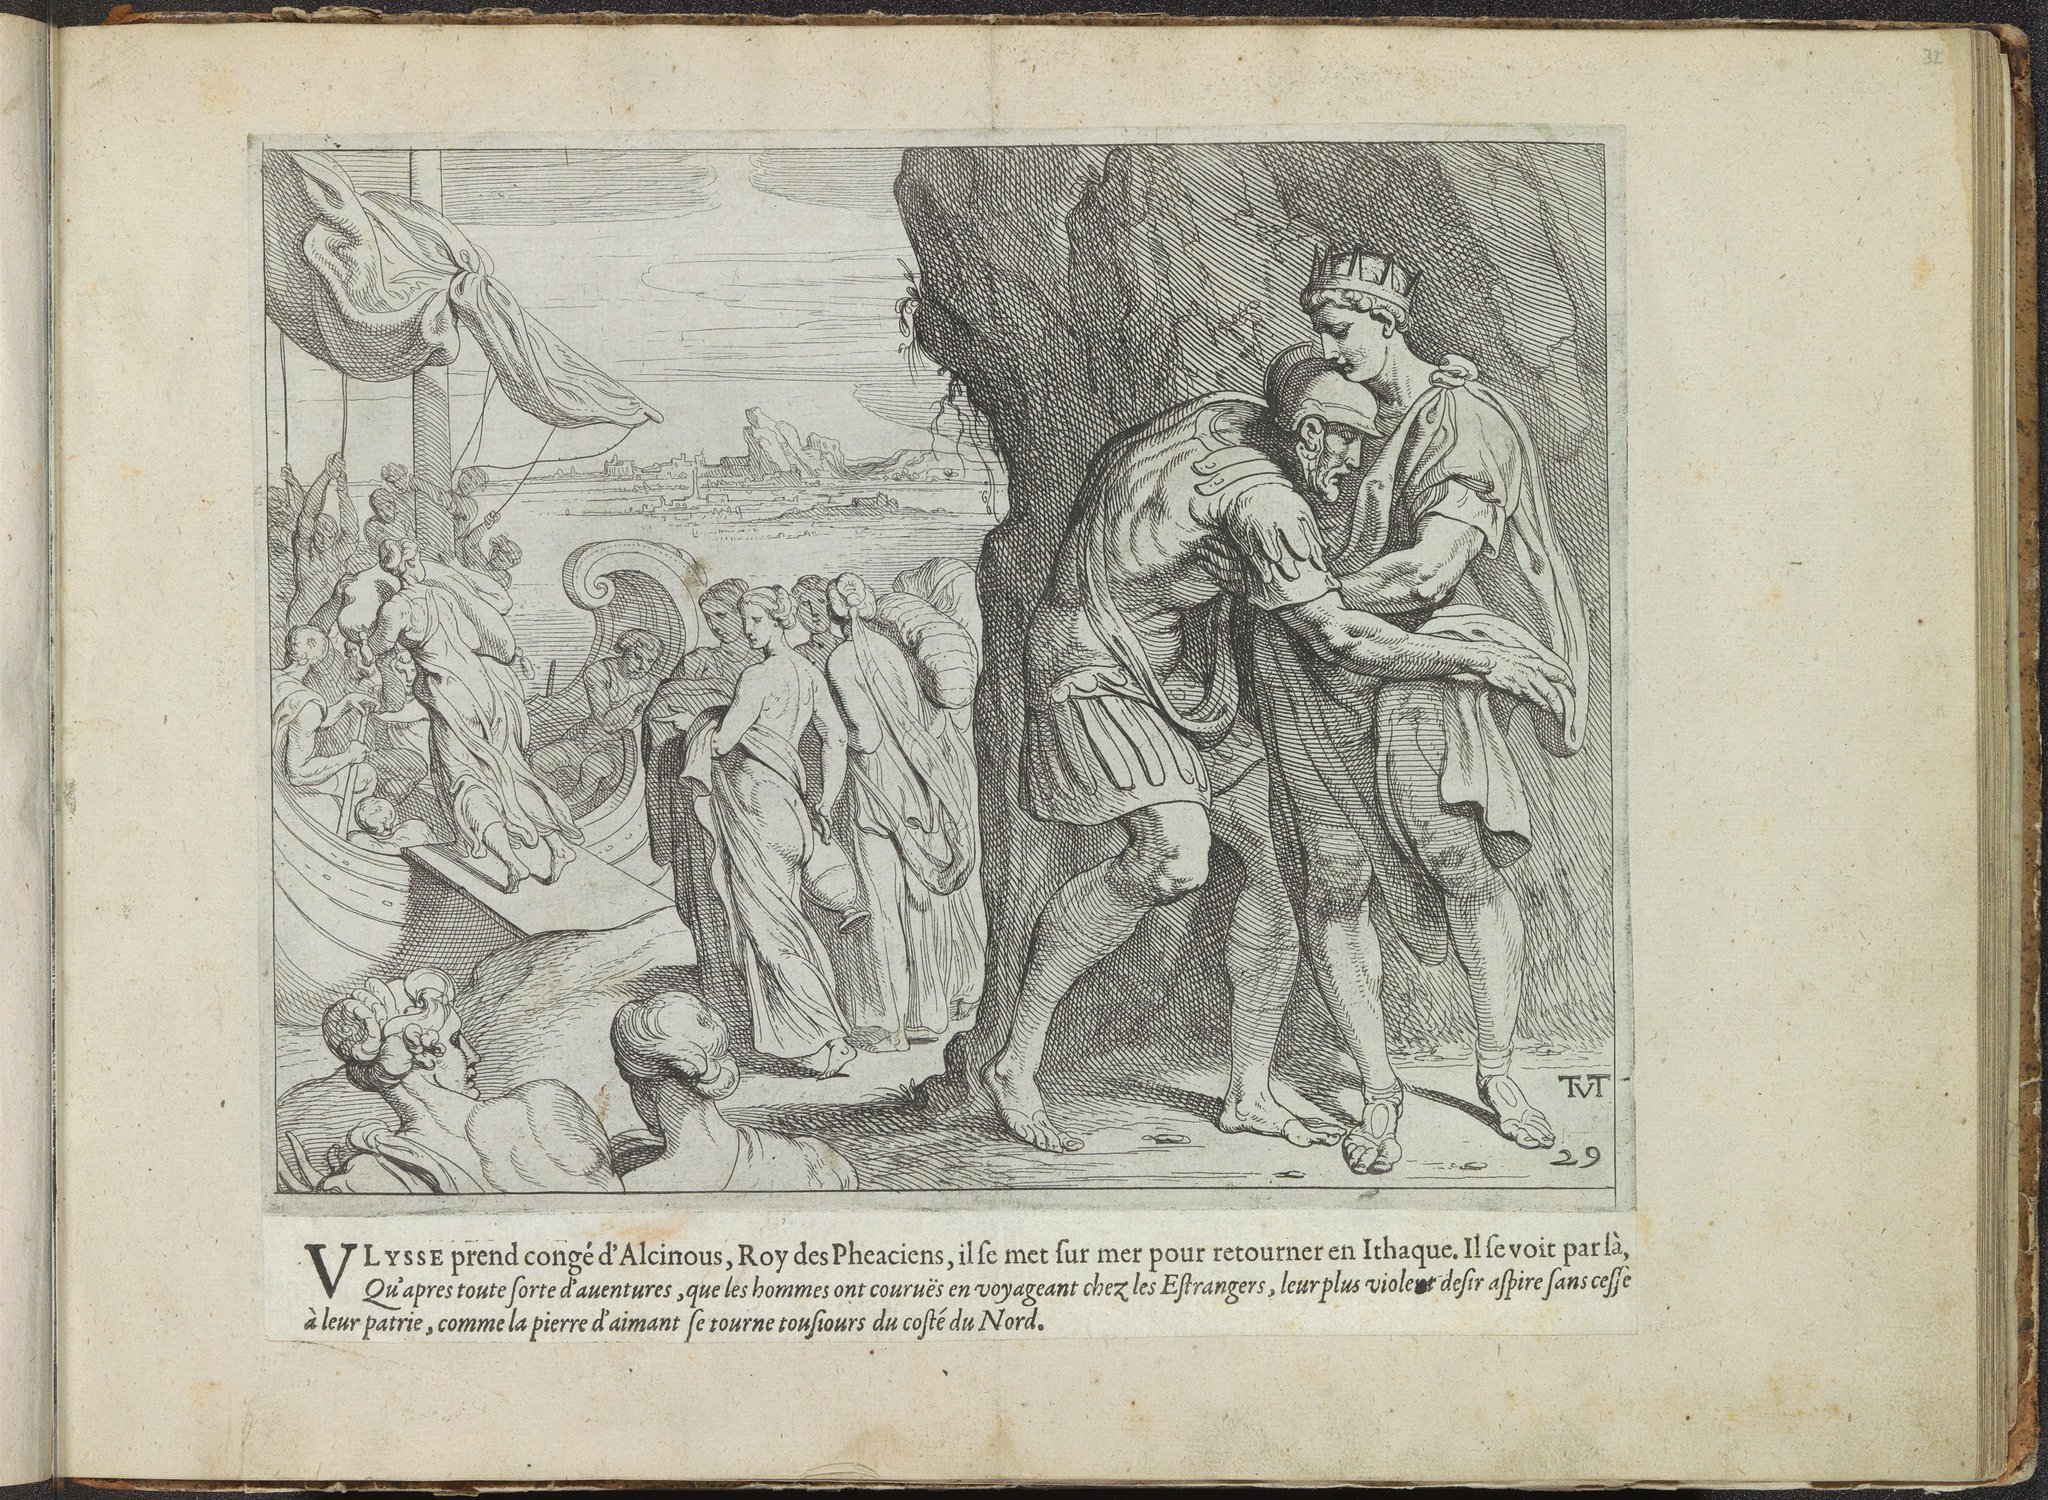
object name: album leaf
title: De werken van Odysseus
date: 1633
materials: paper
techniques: engraving, etching, letterpress printing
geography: paris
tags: ulysses at alcinous' court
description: Odysseus neemt afscheid van koning Alcinoüs. Op de achtergrond maken de Faiaken een schip klaar om Odysseus naar Ithaca te varen. De prent maakt deel uit van een album.